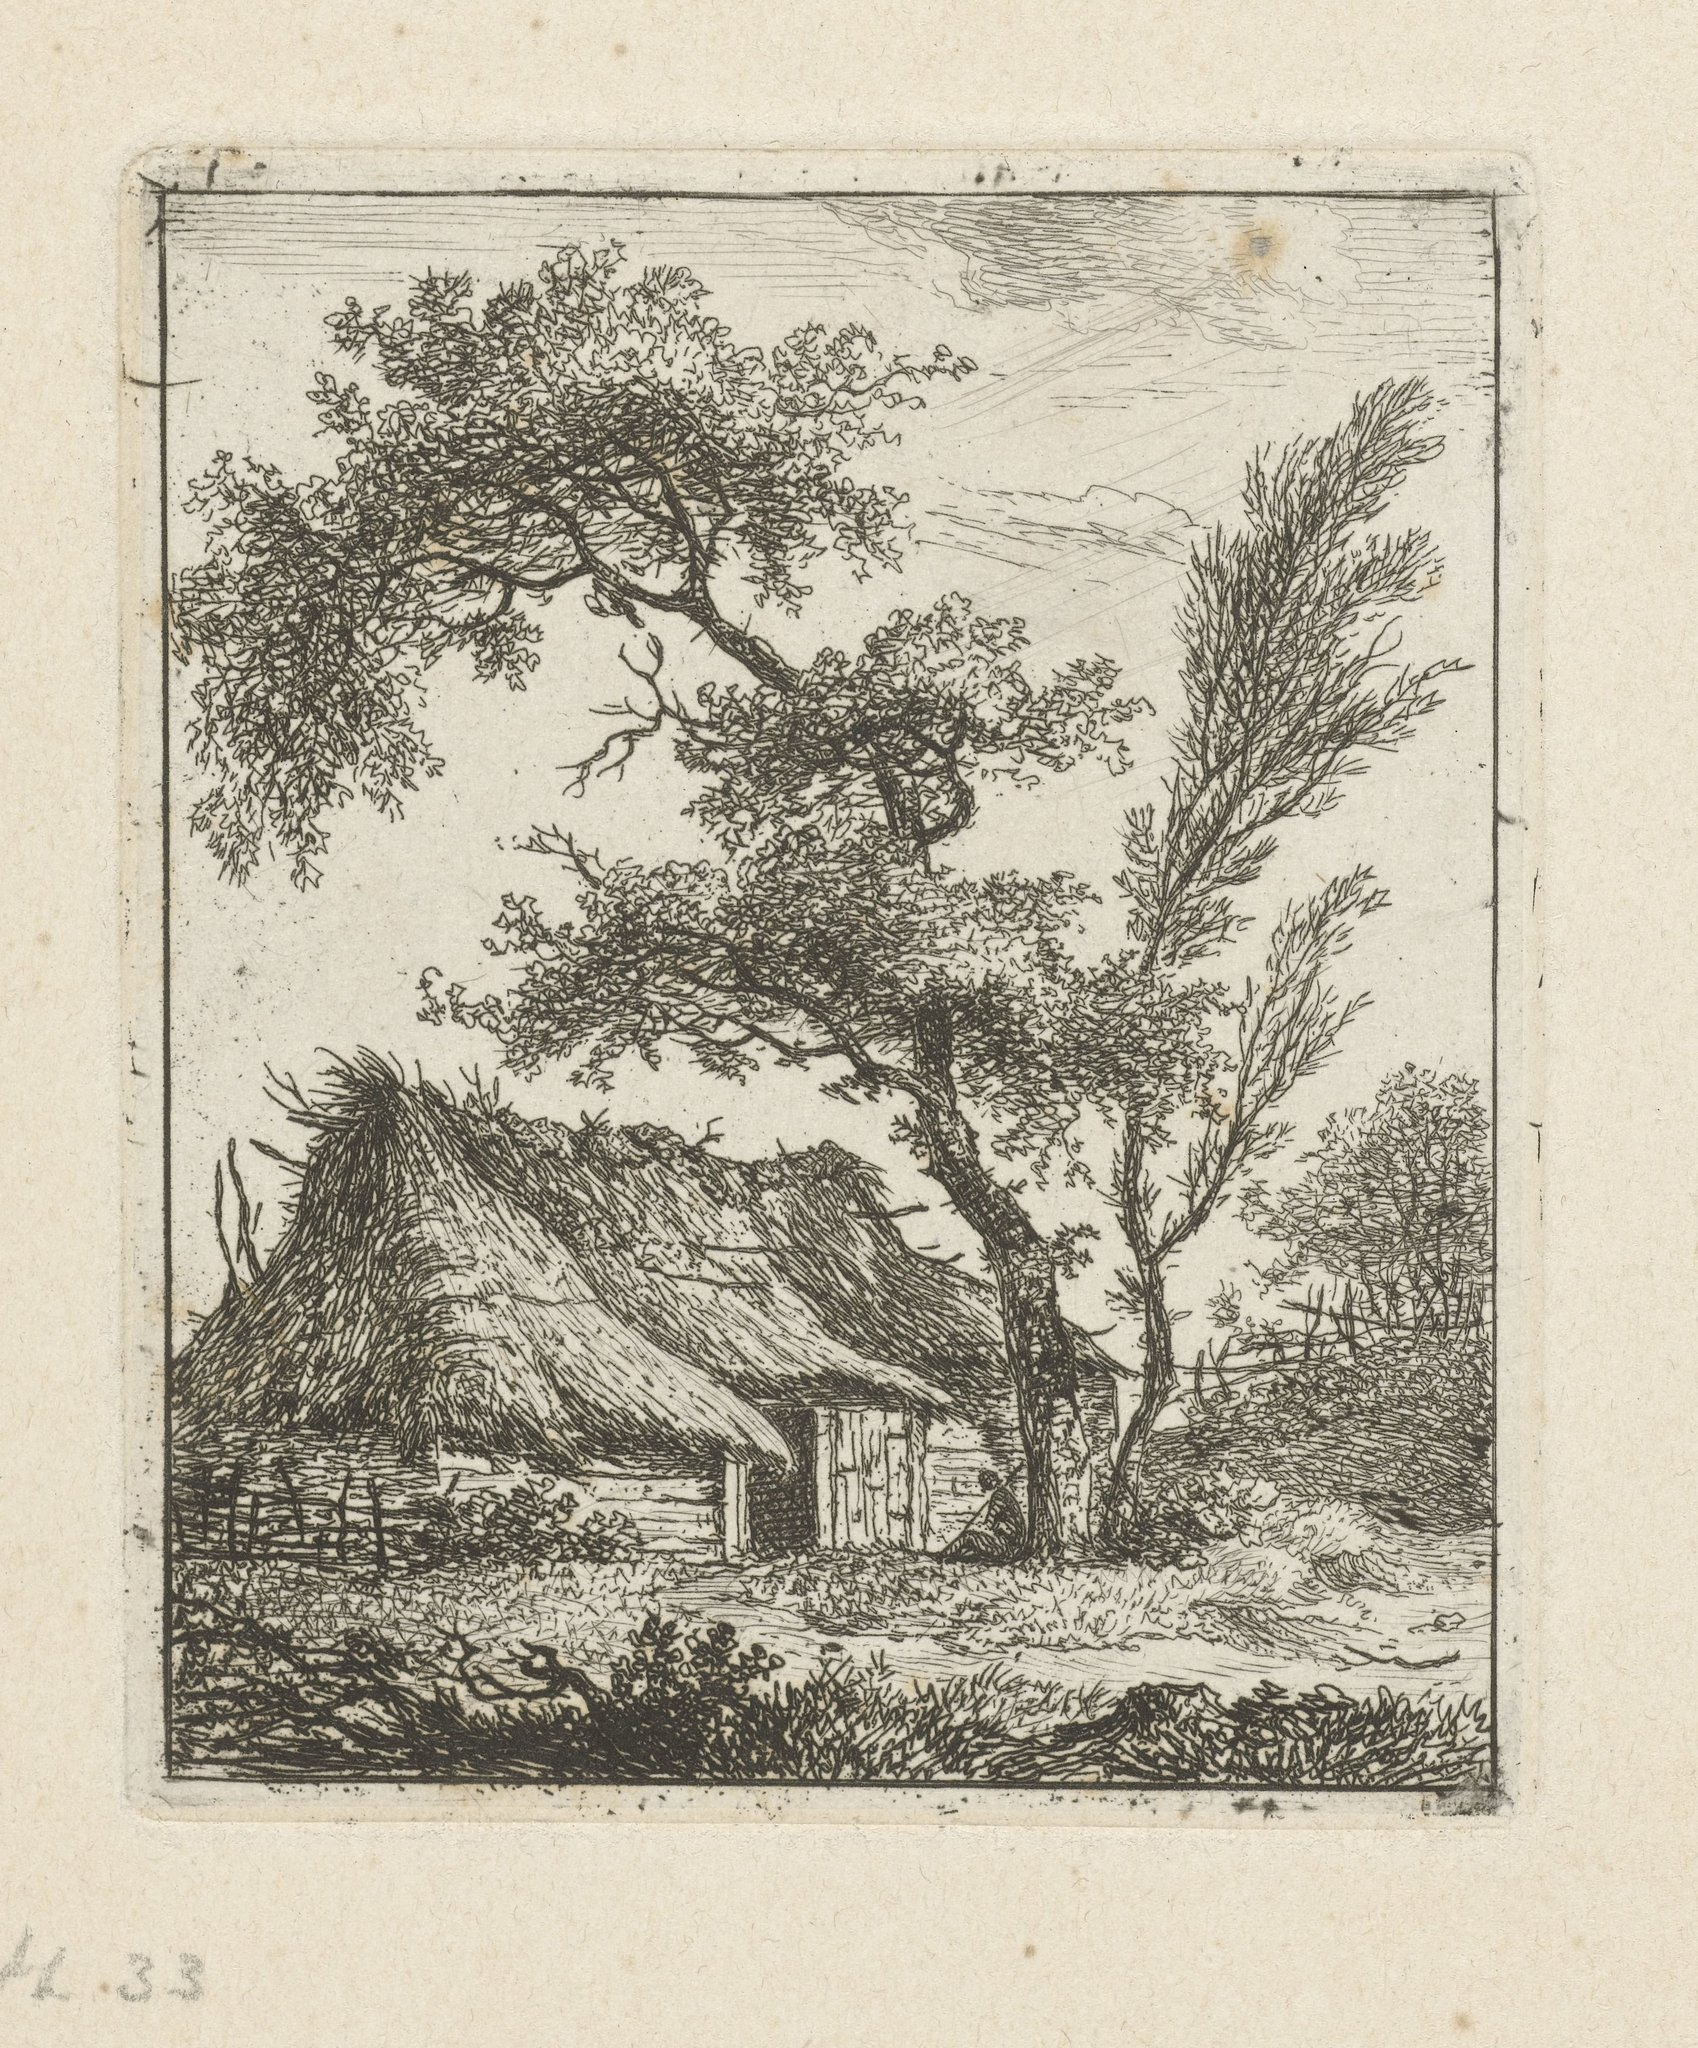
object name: print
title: Boerderij met rieten dak en twee bomen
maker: hermanus fock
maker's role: conservator, draughtsman, painter, print maker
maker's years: 1766-1822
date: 1781-1822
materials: paper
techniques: etching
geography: amsterdam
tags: farm or solitary house in landscape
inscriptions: collector's mark: Lugt 2228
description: Gezicht op een boerderij met een rieten dak. Tegenover de deuropening zit een persoon tegen een hoge boom aan.